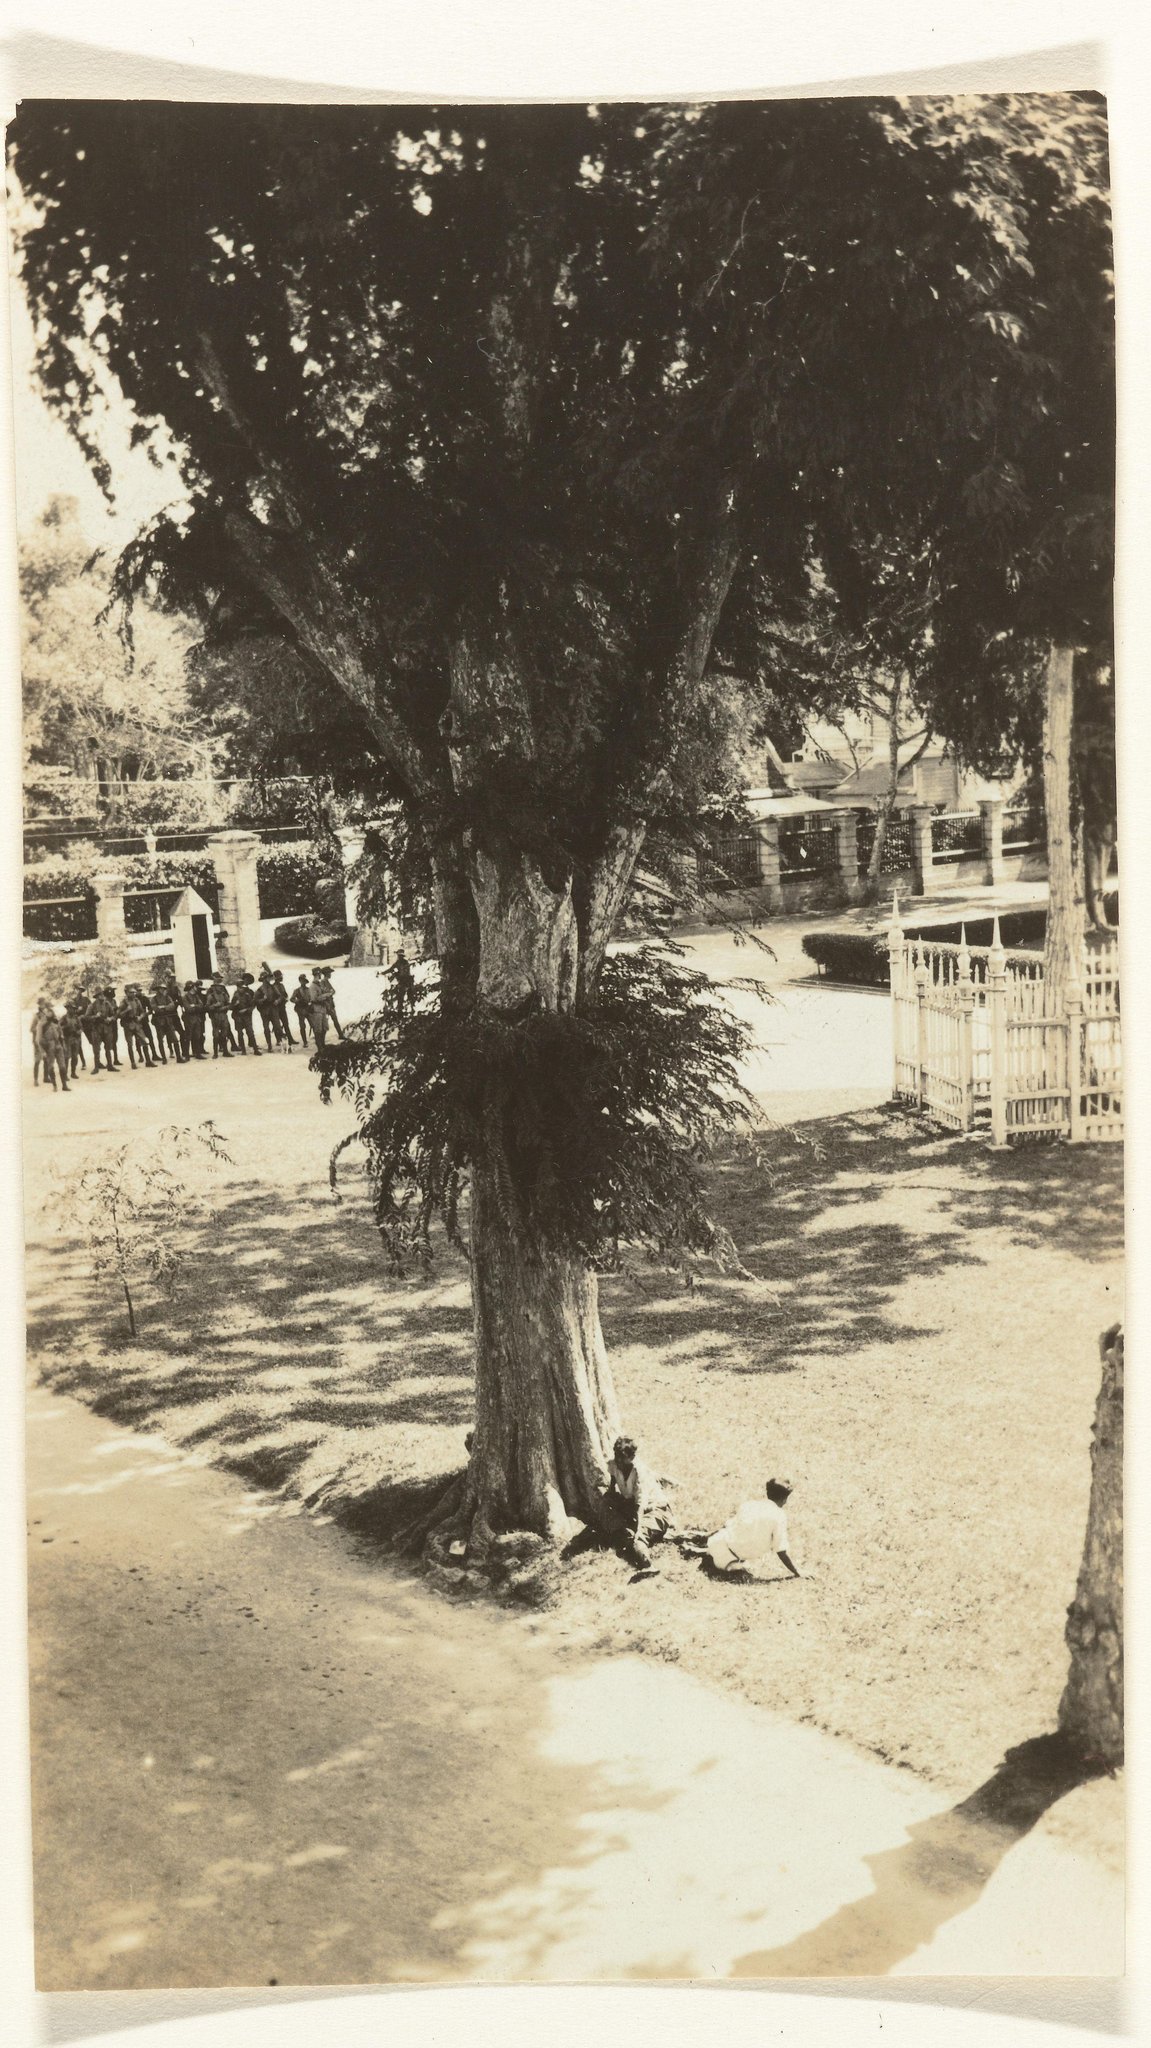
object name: photograph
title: Zwarte Dinsdag in Paramaribo, 7 februari 1933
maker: Anonymous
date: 1933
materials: photographic support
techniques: photography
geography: suriname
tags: anton de kom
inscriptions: inscription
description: Slachtoffers van de schietpartij op 7 februari 1933 onder een boom op het Gouvernementsplein in Paramaribo. De Surinaamse anti-koloniale activist en schrijver Anton de Kom (1898-1945) werd op 1 februari 1933 gearresteerd wegens 'communistische agitatie'. Op 7 februari werd er voor hem gedemonstreerd op het Gouvernementsplein in Paramaribo. Toen de menigte opdrong, kreeg de politie het bevel te schieten. Twee doden en 22 gewonden waren het gevolg. De gewonden werden per kar naar het ziekenhuis vervoerd. De Kom werd op 10 mei, na drie maanden gevangenschap, zonder proces vrijgelaten en door het koloniaal bestuur met zijn gezin op de boot naar Nederland gezet. ‘Zwarte Dinsdag’ markeert een belangrijk moment in het Surinaamse bewustzijn.